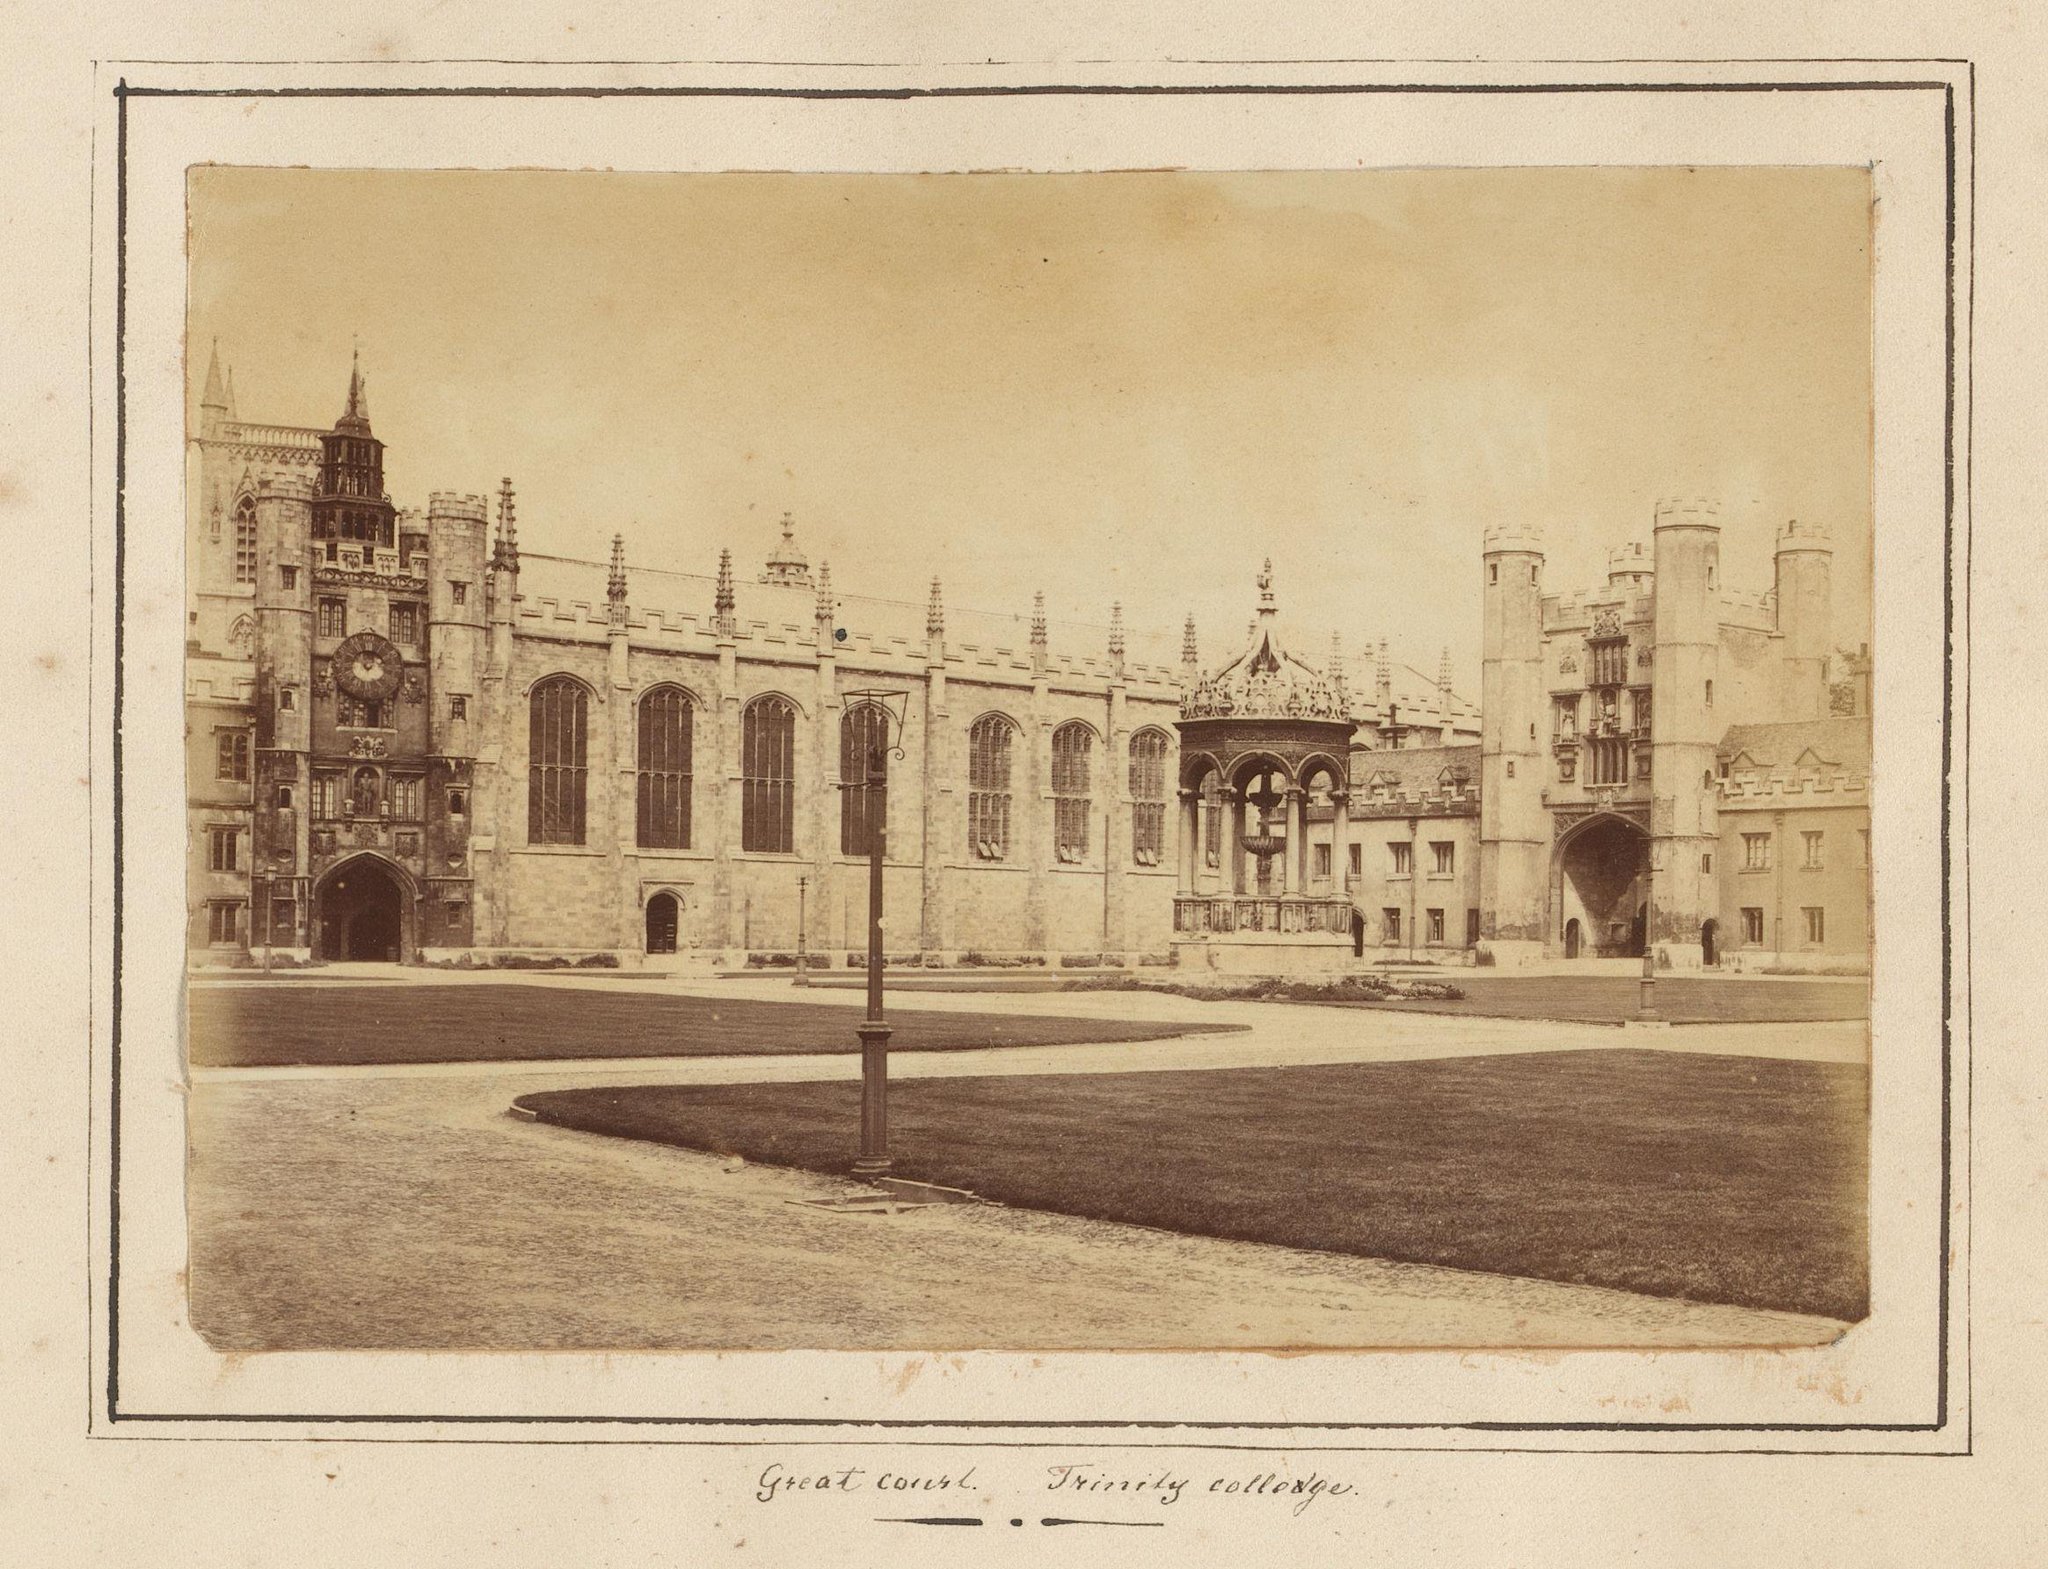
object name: photograph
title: Great court, Trinity College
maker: Anonymous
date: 1865-1890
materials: paper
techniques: albumen print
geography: cambridge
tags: façade of inner court, university building, college